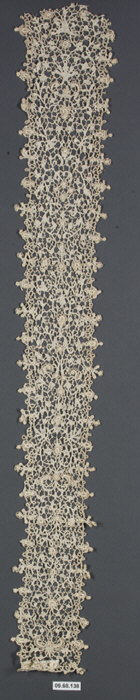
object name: lappet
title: Half lappet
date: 1601-1700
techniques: lace